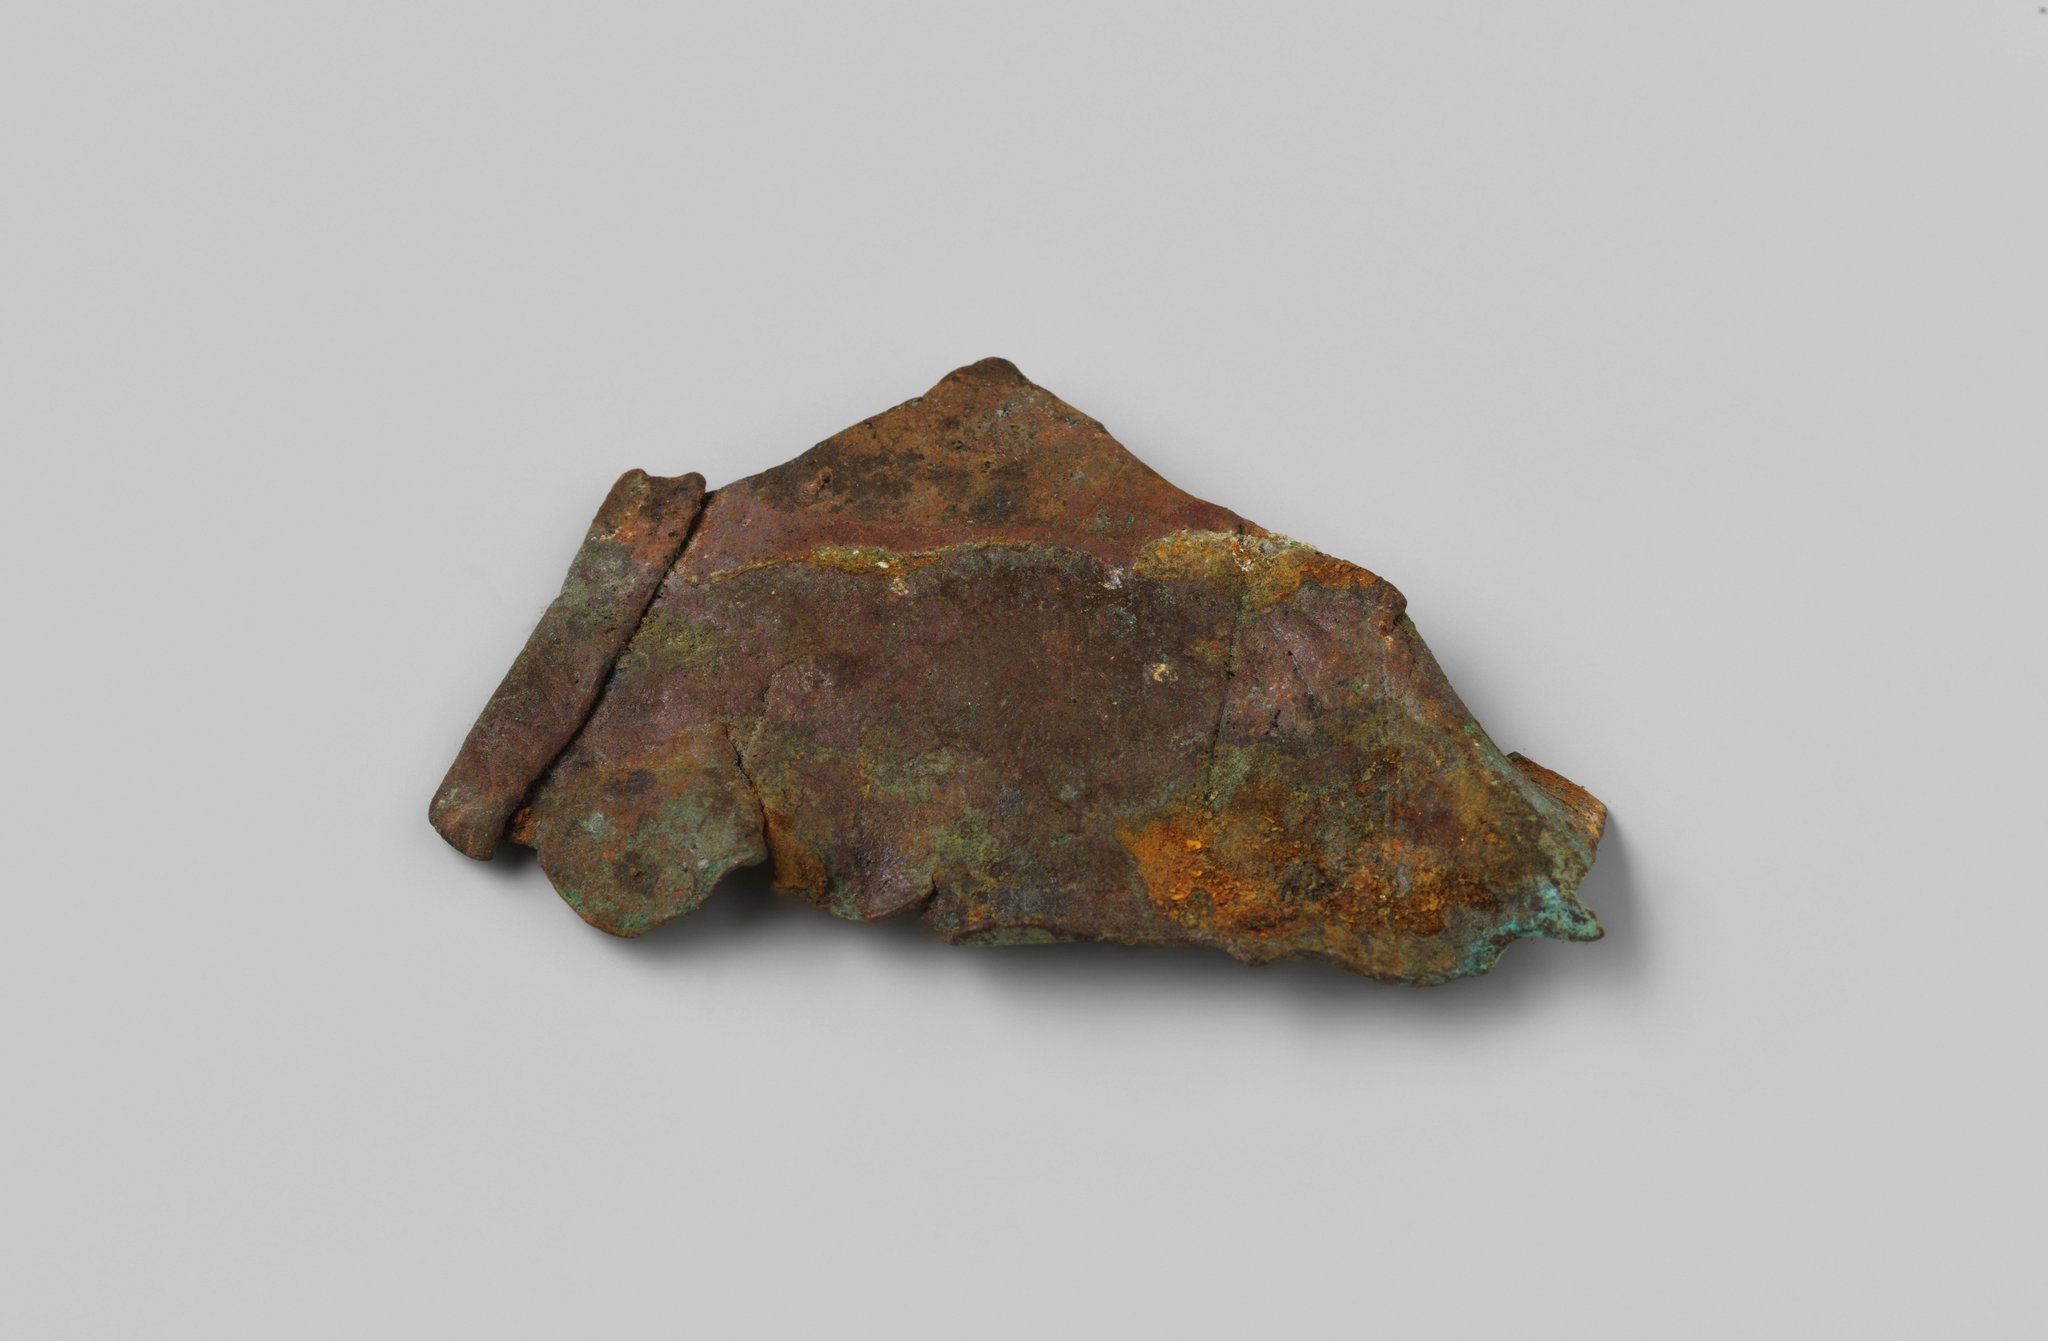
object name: fragment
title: Fragment koperen plaatwerk uit het wrak van de Oost-Indiëvaarder Hollandia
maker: Anonymous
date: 1700-1743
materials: copper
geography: netherlands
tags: verenigde oostindische compagnie, hollandia (schip), annet